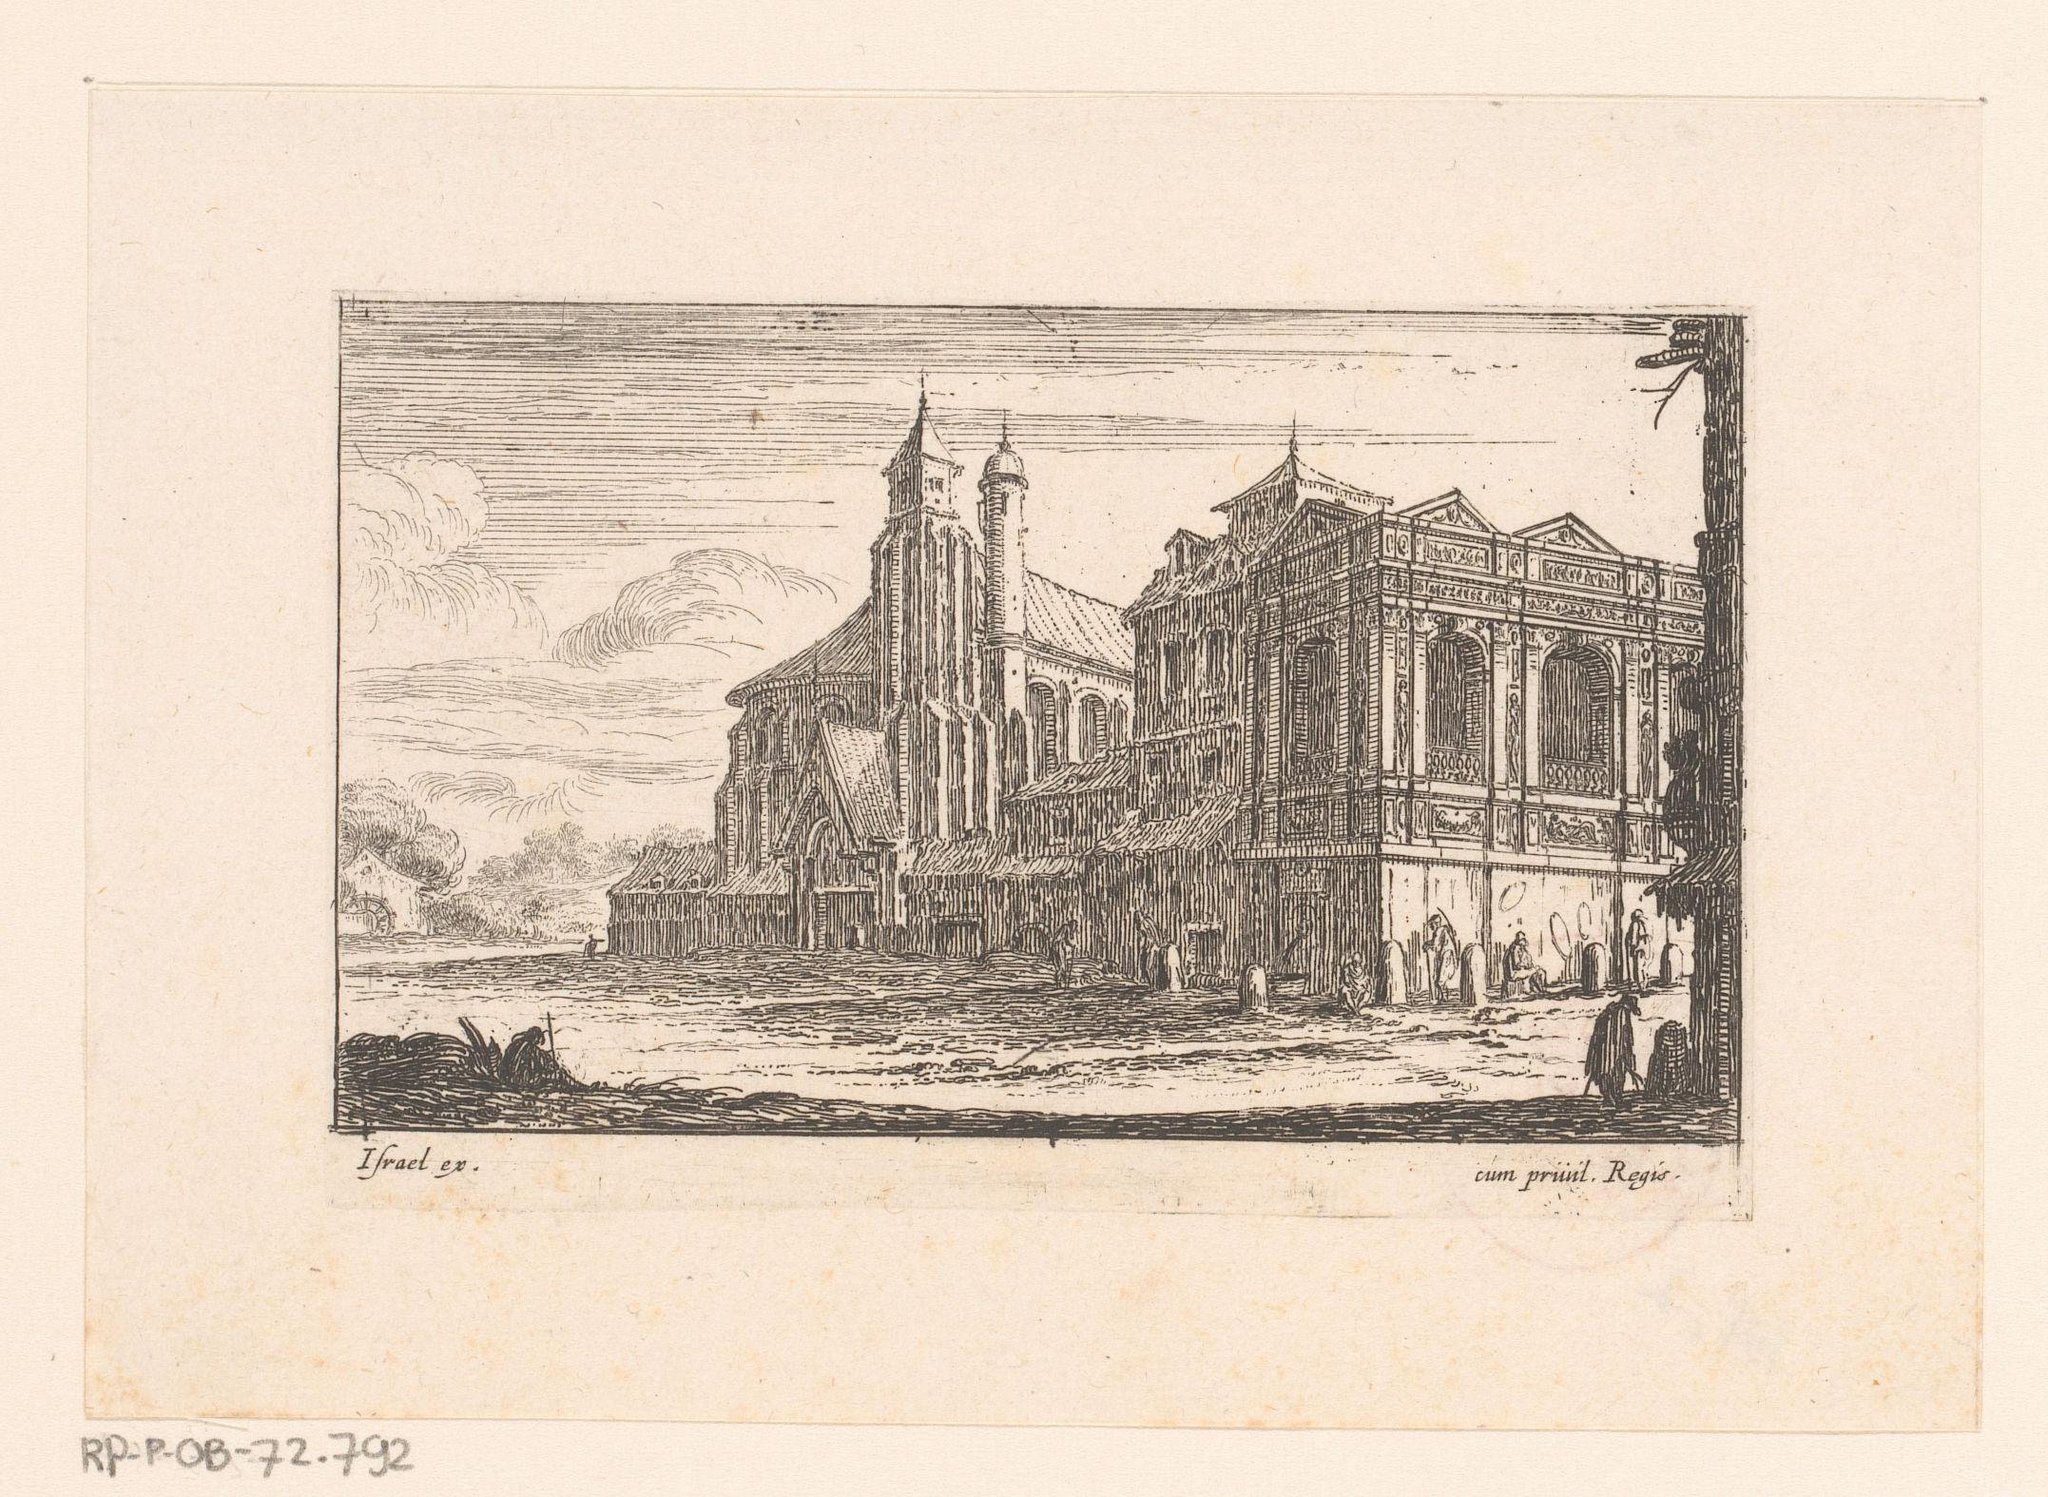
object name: print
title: Diverse gezichten op kerken, kastelen en steden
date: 1631-1661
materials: paper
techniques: etching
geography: france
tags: city-view, and landscape with man-made constructions, ornamental fountain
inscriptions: collector's mark: Lugt 240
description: Prent maakt deel uit van een ongenummerde serie van zeven prenten.